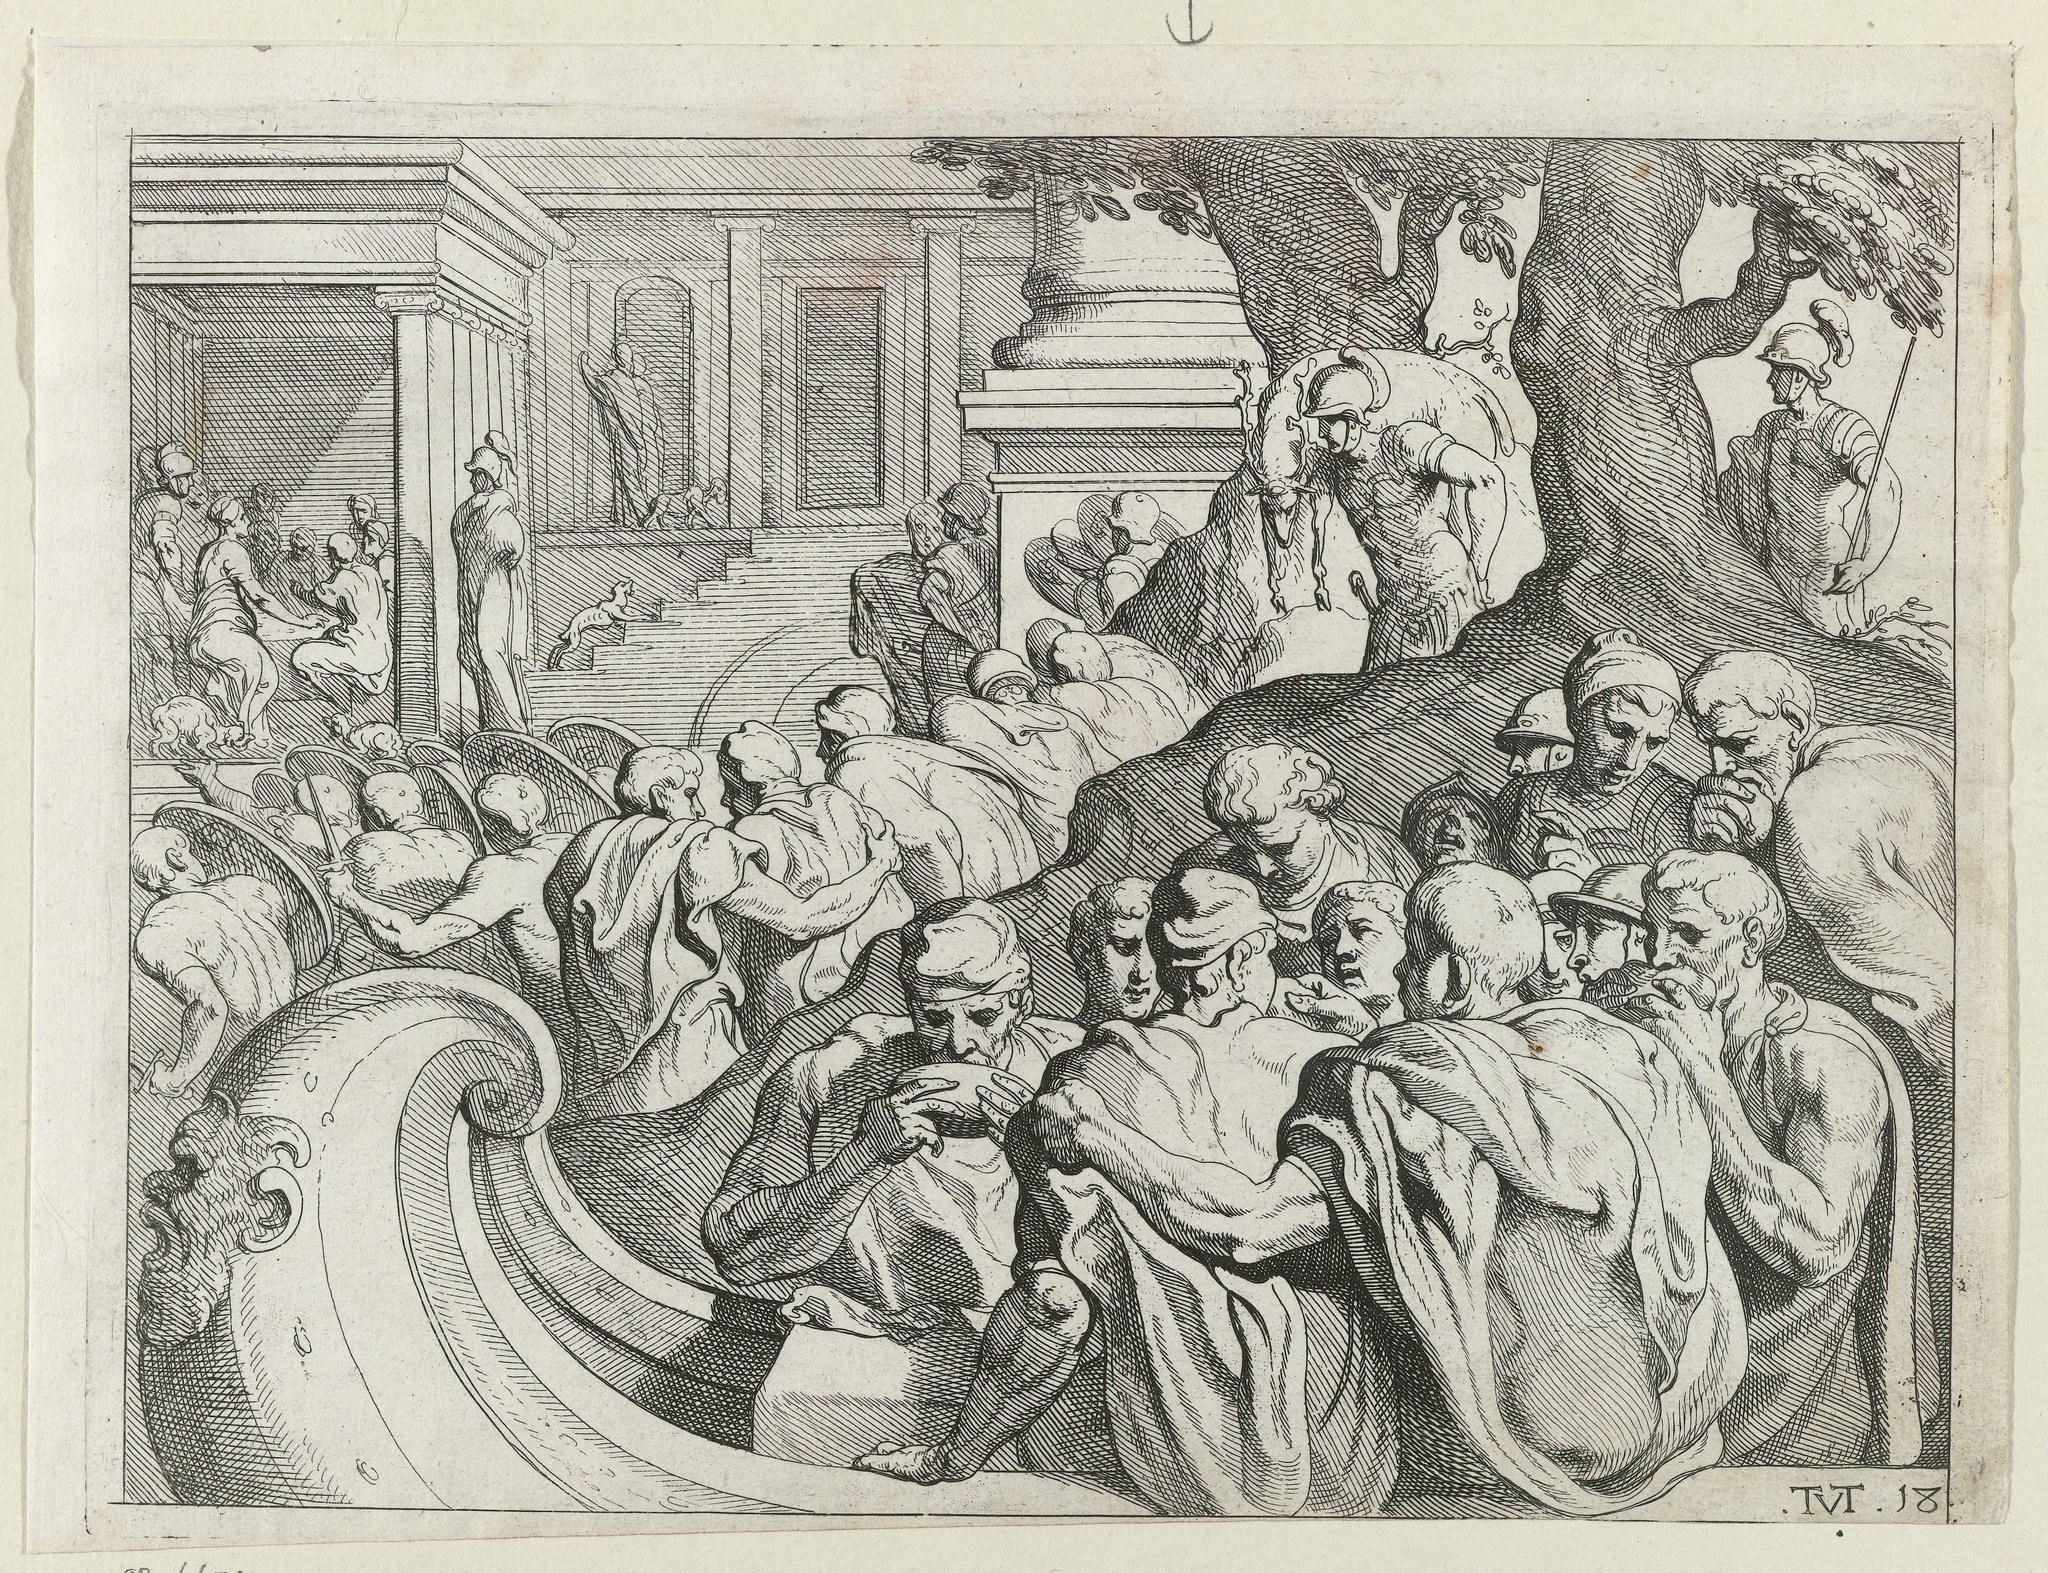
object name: print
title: Odysseus op het eiland van Circe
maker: theodoor van thulden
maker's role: draughtsman, painter, print maker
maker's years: 1606-1669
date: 1632-1633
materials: paper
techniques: engraving, etching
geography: paris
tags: ulysses on the island of circe (homer, odyssey x)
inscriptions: collector's mark: Lugt 2228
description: Odysseus en zijn mannen arriveren op het eiland van Circe. Op de achtergrond het paleis van Circe.